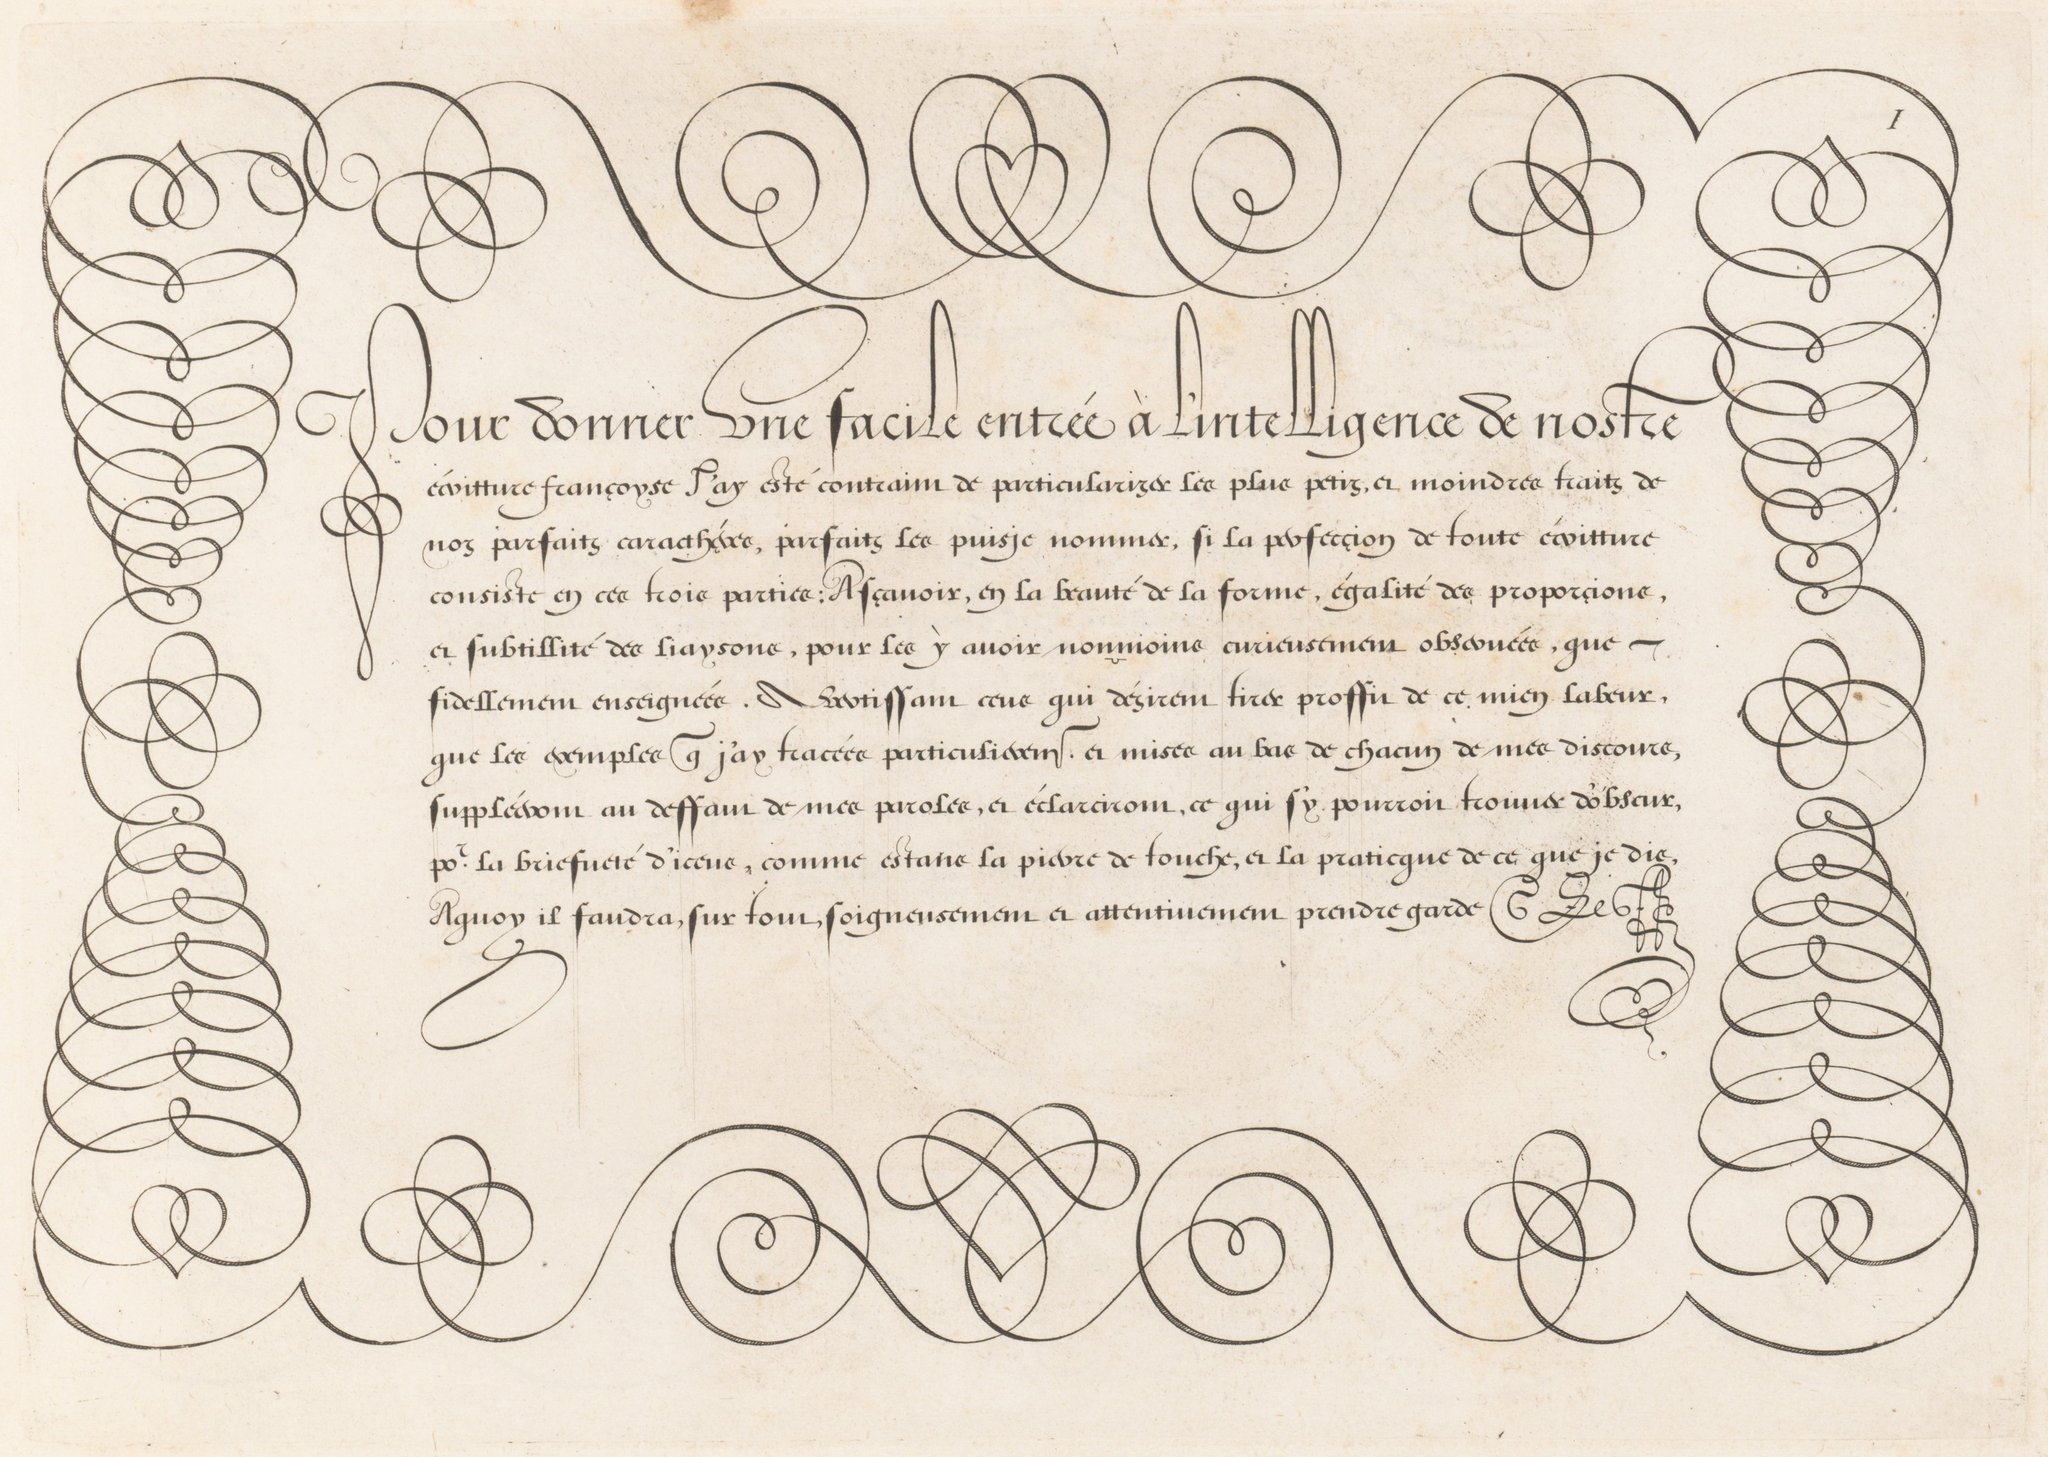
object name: book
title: La Technographie. La Rizographie. La Caligraphie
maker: guillaume le gangneur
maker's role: author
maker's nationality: french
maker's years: 16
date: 1599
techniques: engraving, woodcut